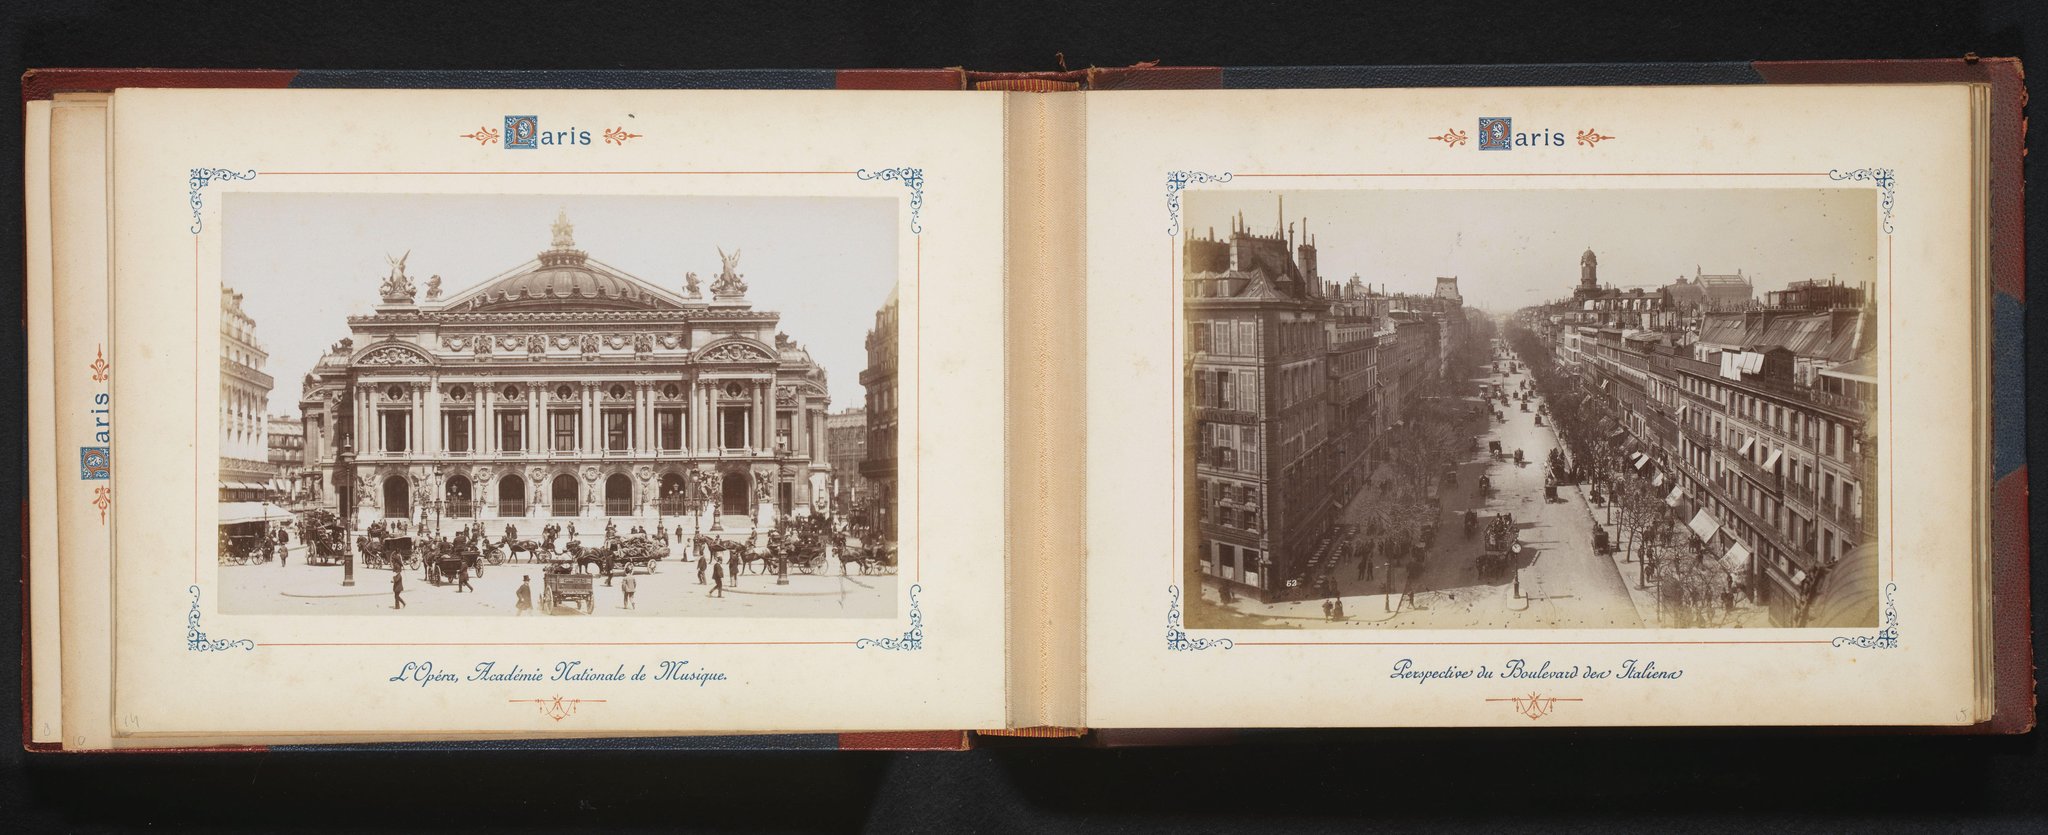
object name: page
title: Gezicht op de Boulevard des Italiens te Parijs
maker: Anonymous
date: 1879-1889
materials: photographic support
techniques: albumen print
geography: paris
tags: four-wheeled, animal-drawn vehicle, e.g.: cab, carriage, coach, avenue, boulevard, promenade, esplanade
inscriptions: number: ‘52’